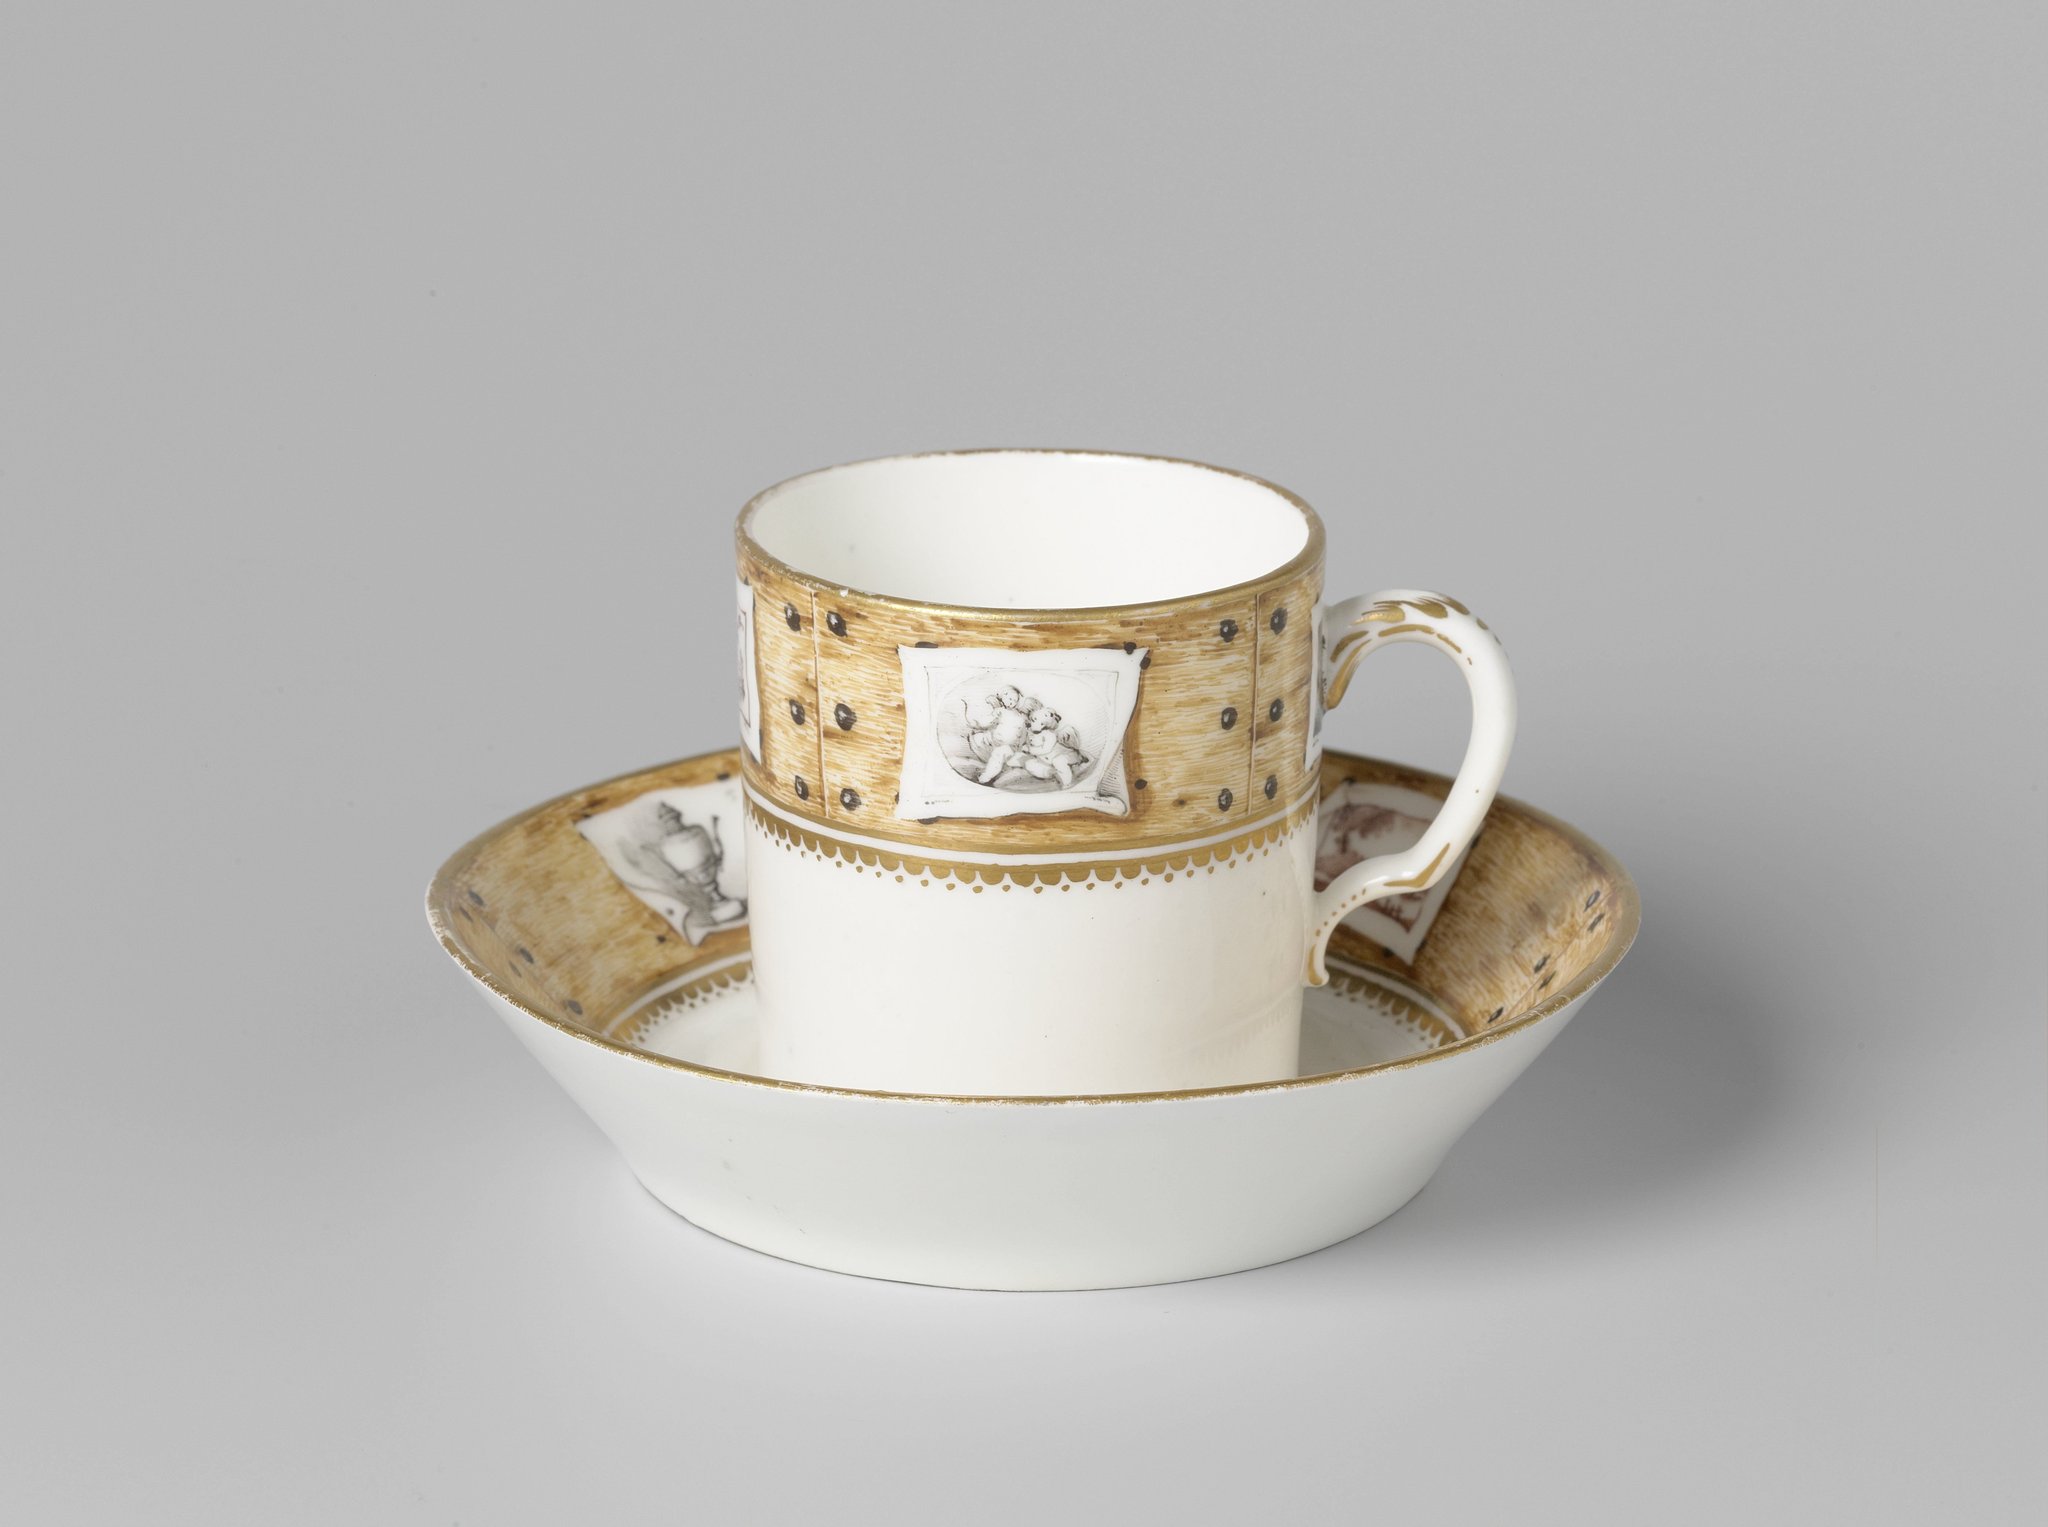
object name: cup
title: Kop, beschilderd met planken waarop prenten zijn bevestigd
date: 1778-1782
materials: porcelain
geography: loosdrecht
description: Coffee cup and saucer. Porcelain. Loosdrecht, c. 1778 - 1782. Factory of Joannes de Mol.